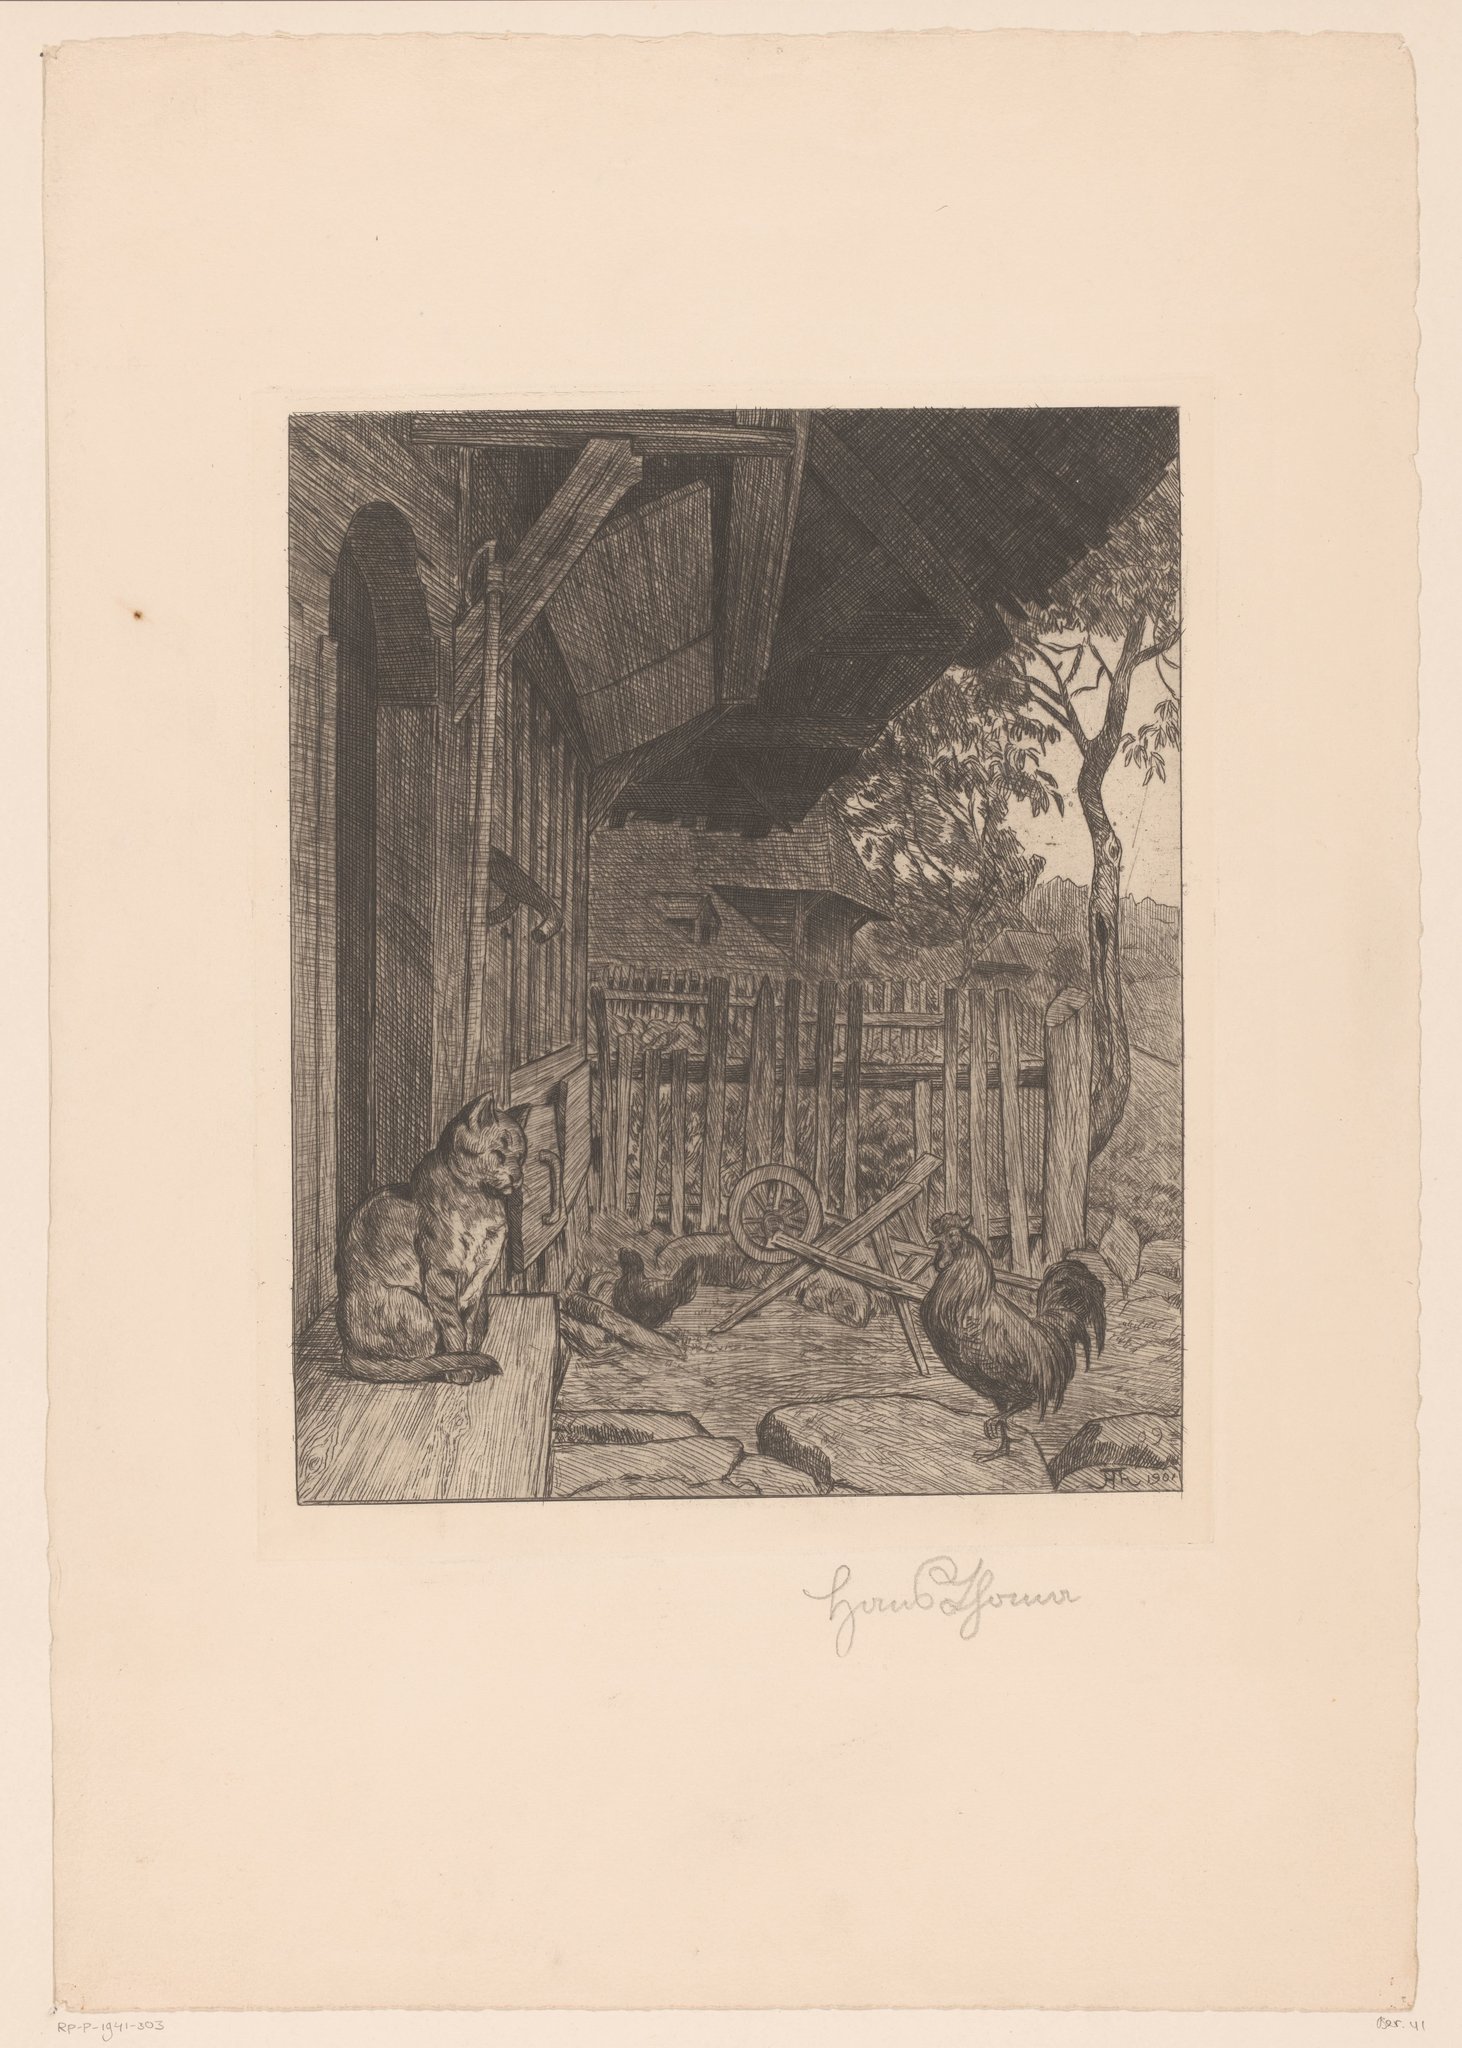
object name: print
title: Kat en haan voor een huis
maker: hans thoma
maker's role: painter, print maker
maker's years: 1839-1924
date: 1901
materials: paper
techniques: etching, intaglio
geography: karlsruhe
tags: cat, fowl (cock, hen, chicken, etc.)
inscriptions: collector's mark: Lugt 2760, collector's mark: Lugt 2228